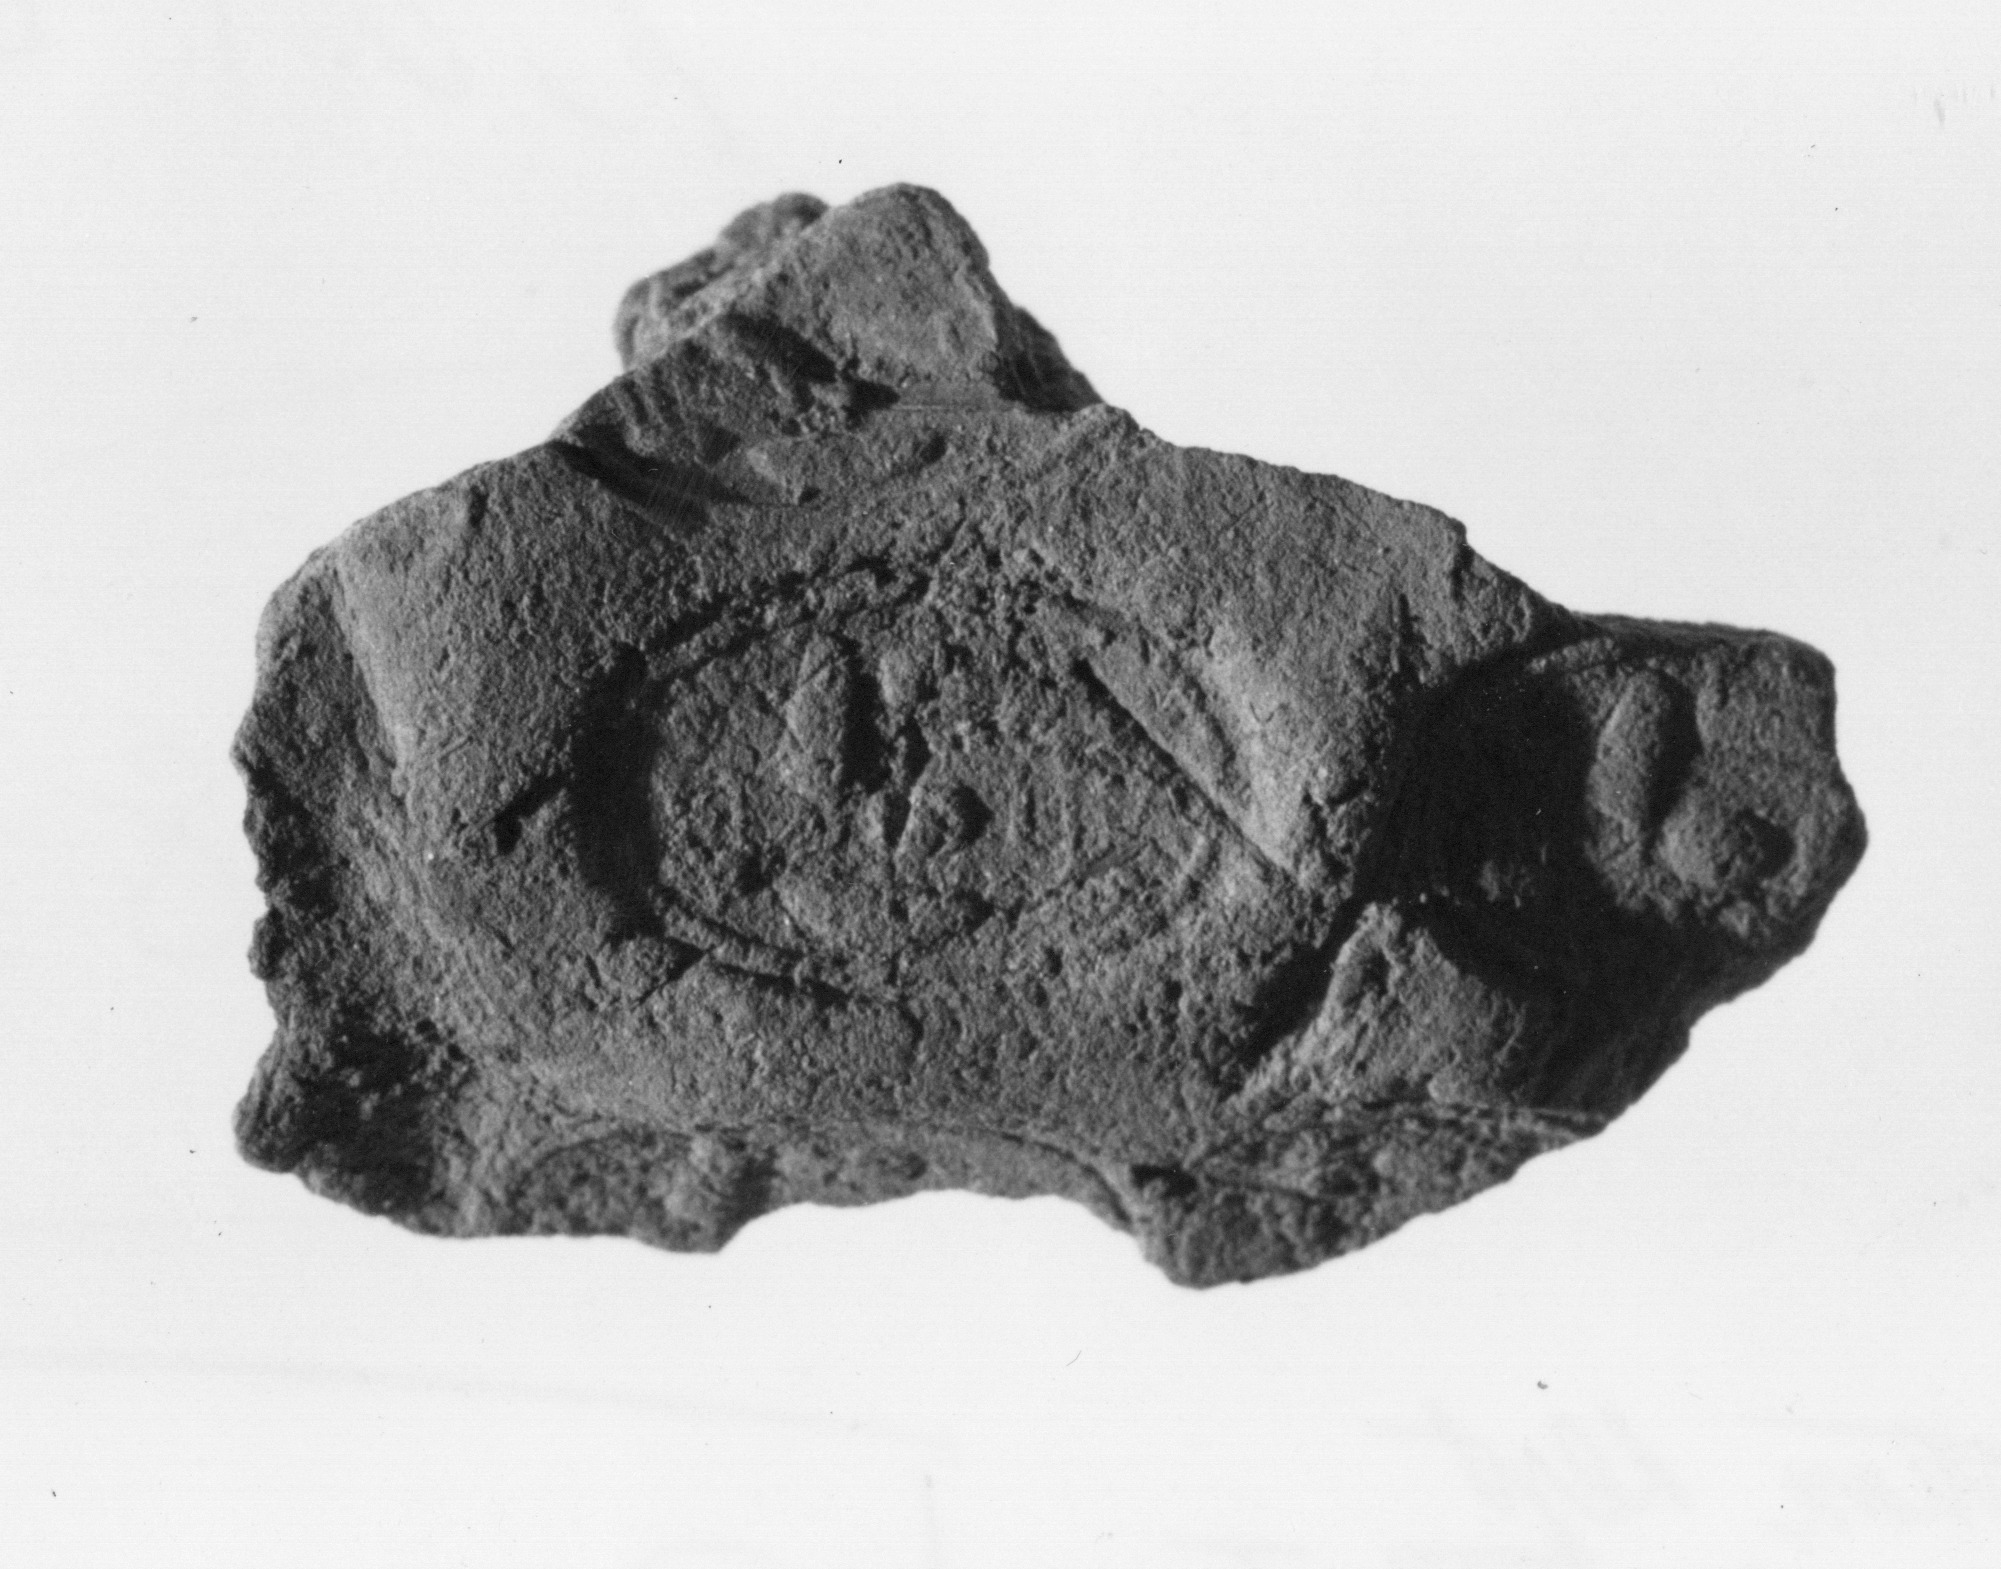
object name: sealing, upper egypt, lower egypt, amun re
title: Document Sealing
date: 1390-1352 BCE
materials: mud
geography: egypt